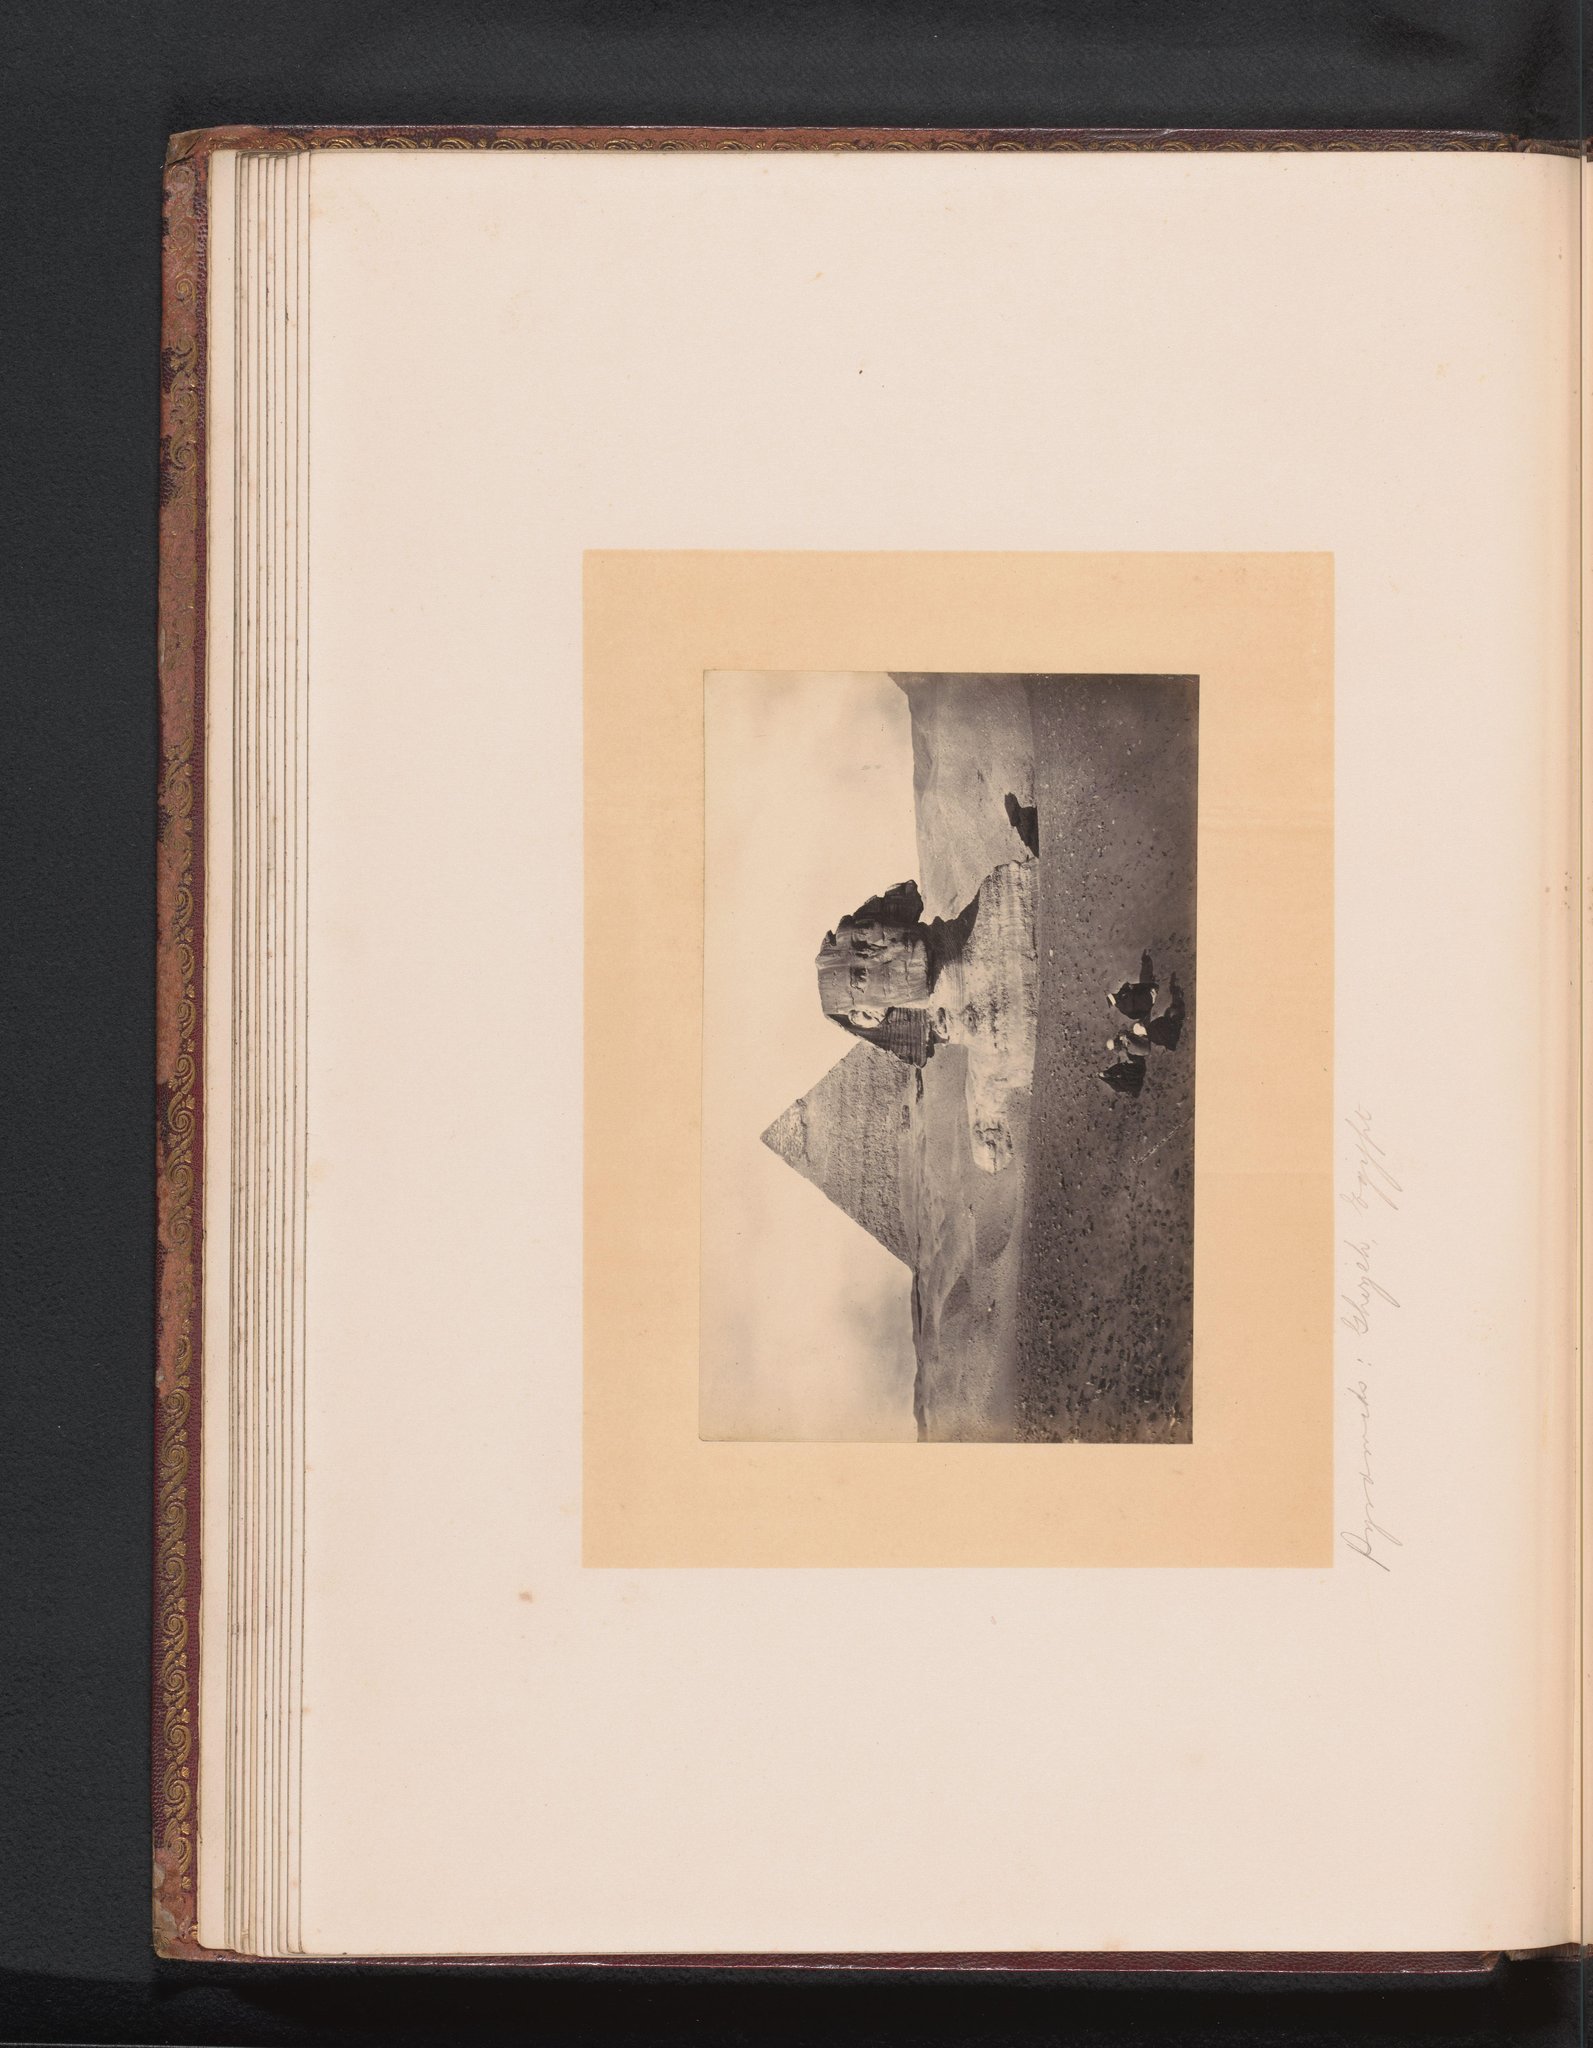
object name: page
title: Gezicht op de Sfinx van Gizeh en de Piramide van Chefren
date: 1870-1875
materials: photographic support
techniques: albumen print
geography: gizeh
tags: sphinx (lion/woman); 'sfinge' (ripa), pyramid (historical grave form)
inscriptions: annotation: ‘Pyramids: Ghizeh, Egypt’